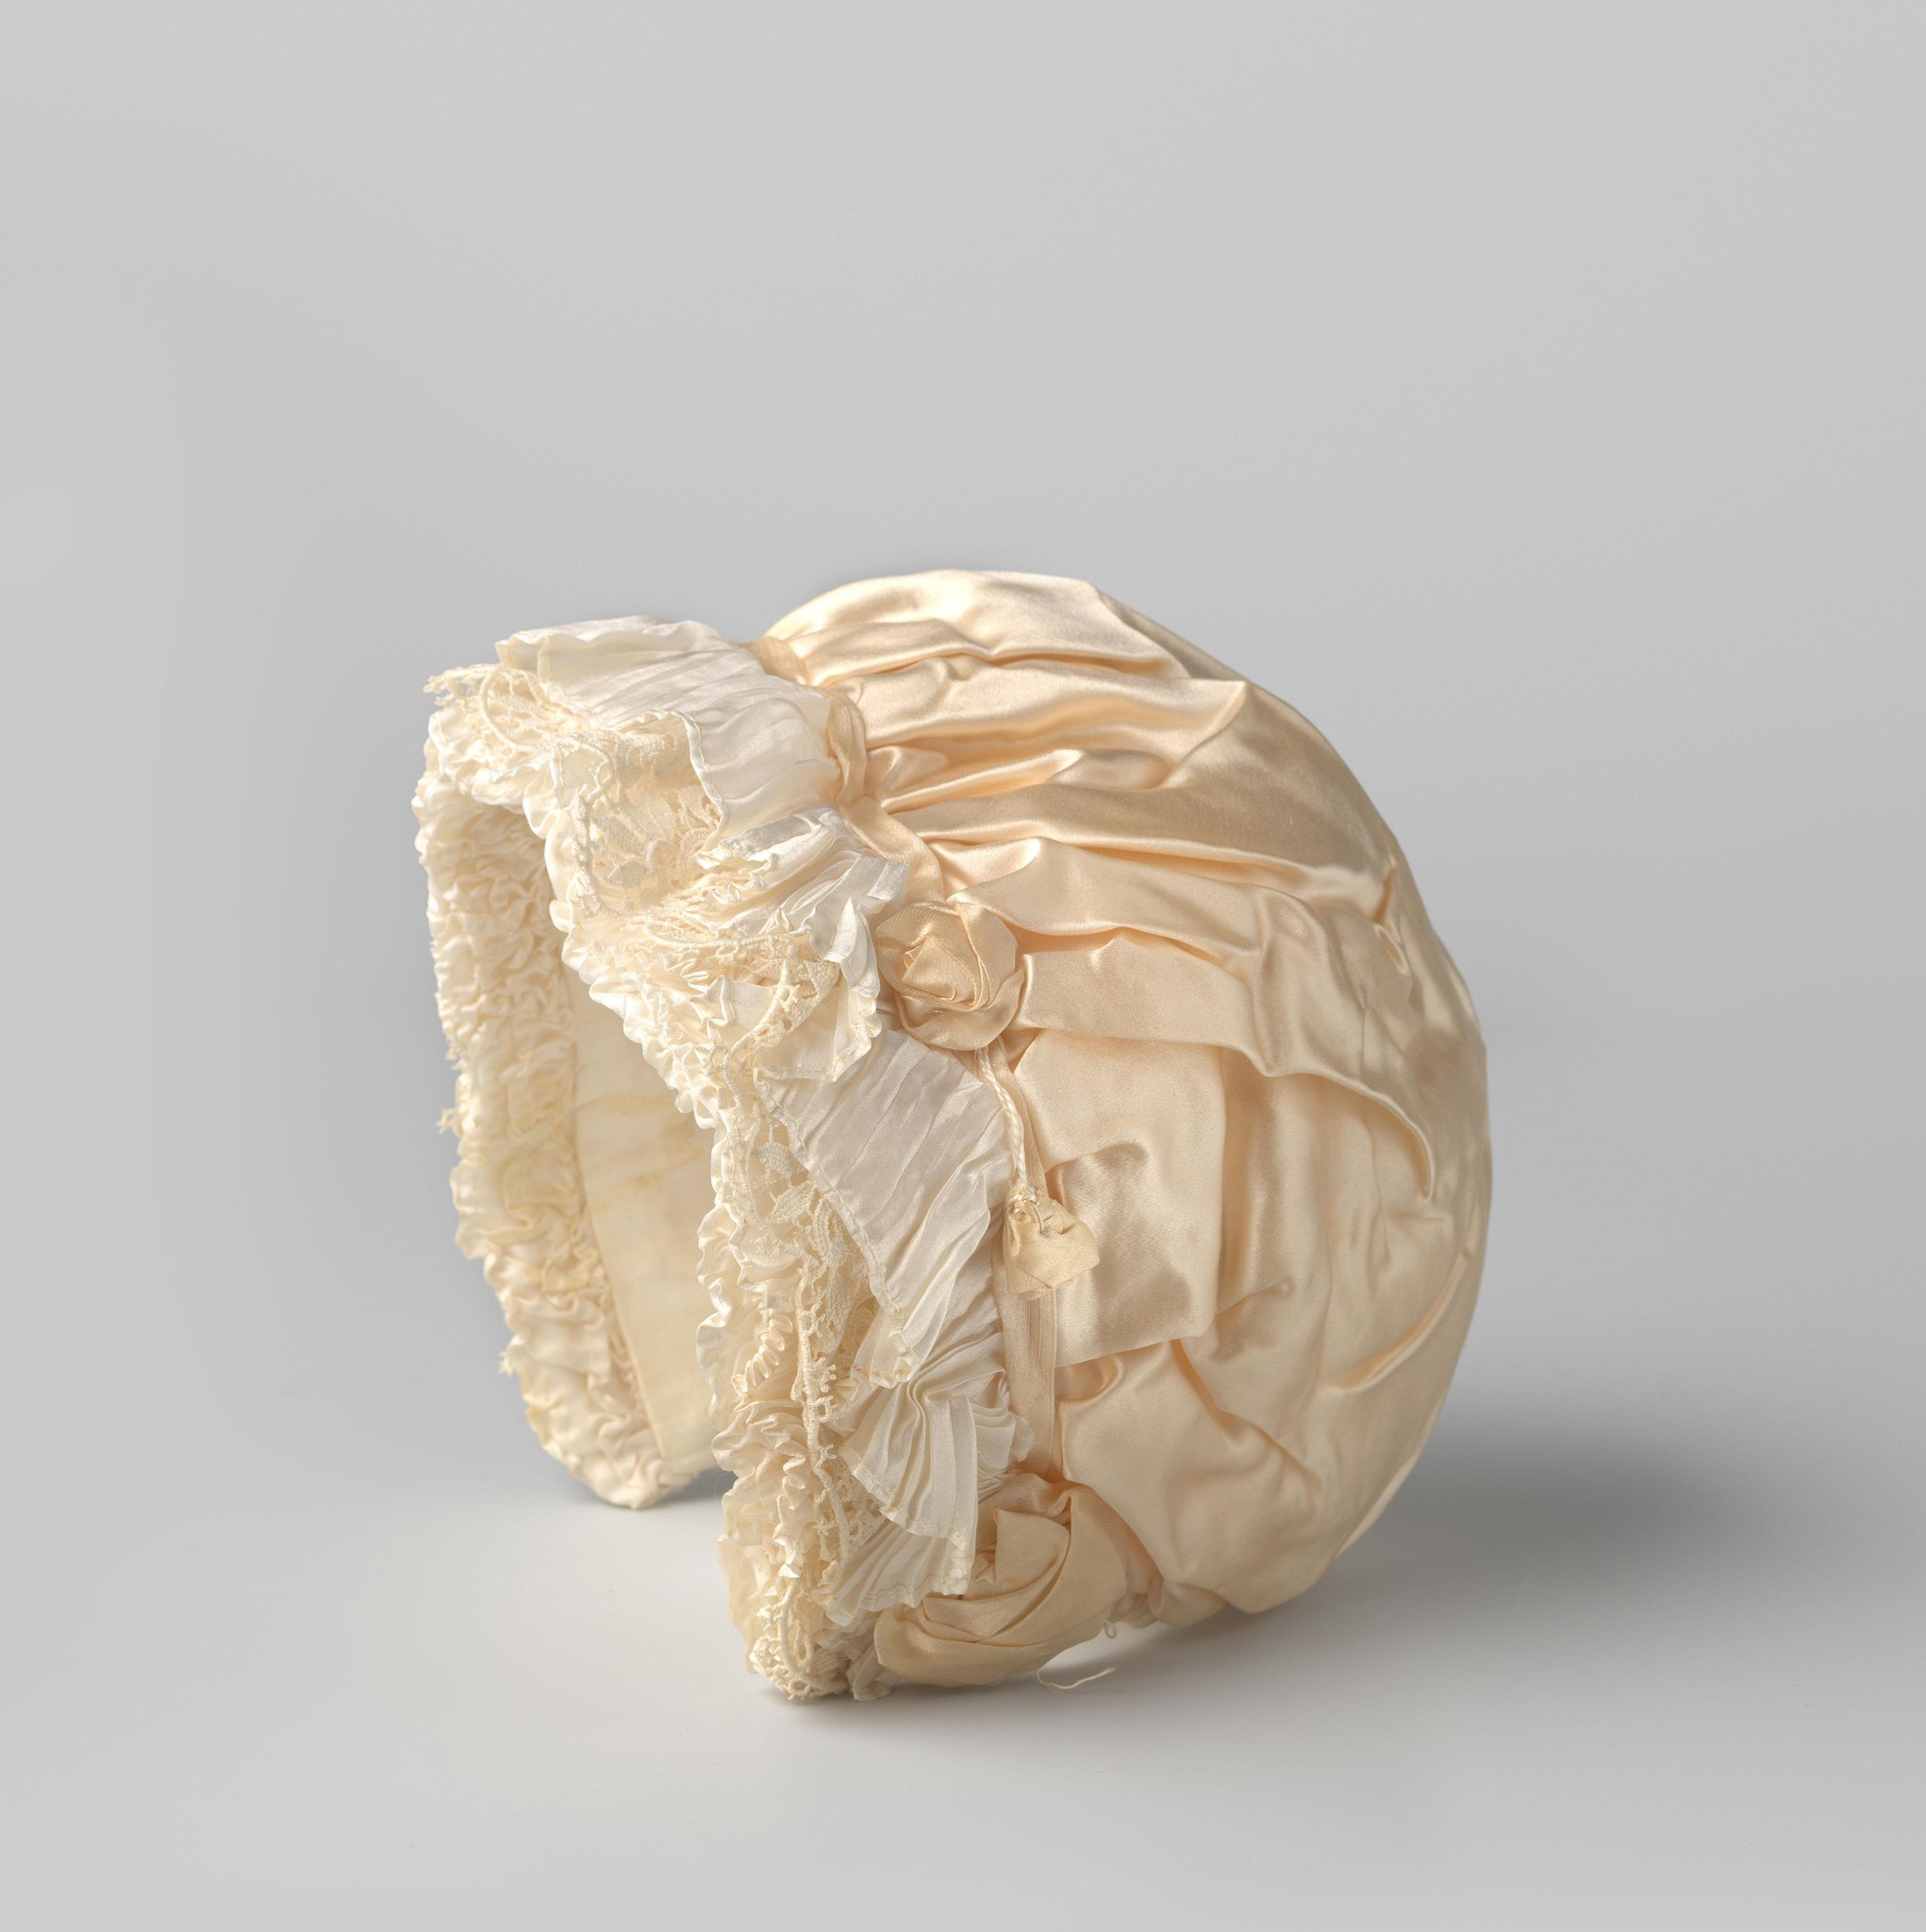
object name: cap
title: Kindermuts met bol van satijn afgezet met dubbele rand van geplisseerde zijde waartussen etskant, versierd met twee grote en twee kleine satijnen rozen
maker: Anonymous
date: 1890-1910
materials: cotton, textile, silk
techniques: lace, pleated, sewing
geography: netherlands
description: Kindermuts met bol van satijn afgezet met dubbele rand van geplisseerde zijde waartussen etskant, versierd met twee satijnen rozen. De bol bestaat uit één geheel met aangezette rand van vlieseline en is gevoerd met wit glaskatoen. Op de smalle rand tussen de bol en de rand is aan de uiteinden een roos van satijn aangebracht. Halverwege het gezicht aan weerskanten een kleinere roos van satijn waarvan aan een gedraaid zijden koordje een rozenknop(/) afhangt. De rand die het gezicht omgeeft, bestaat uit geplisseerde zijde en een strook etskant.